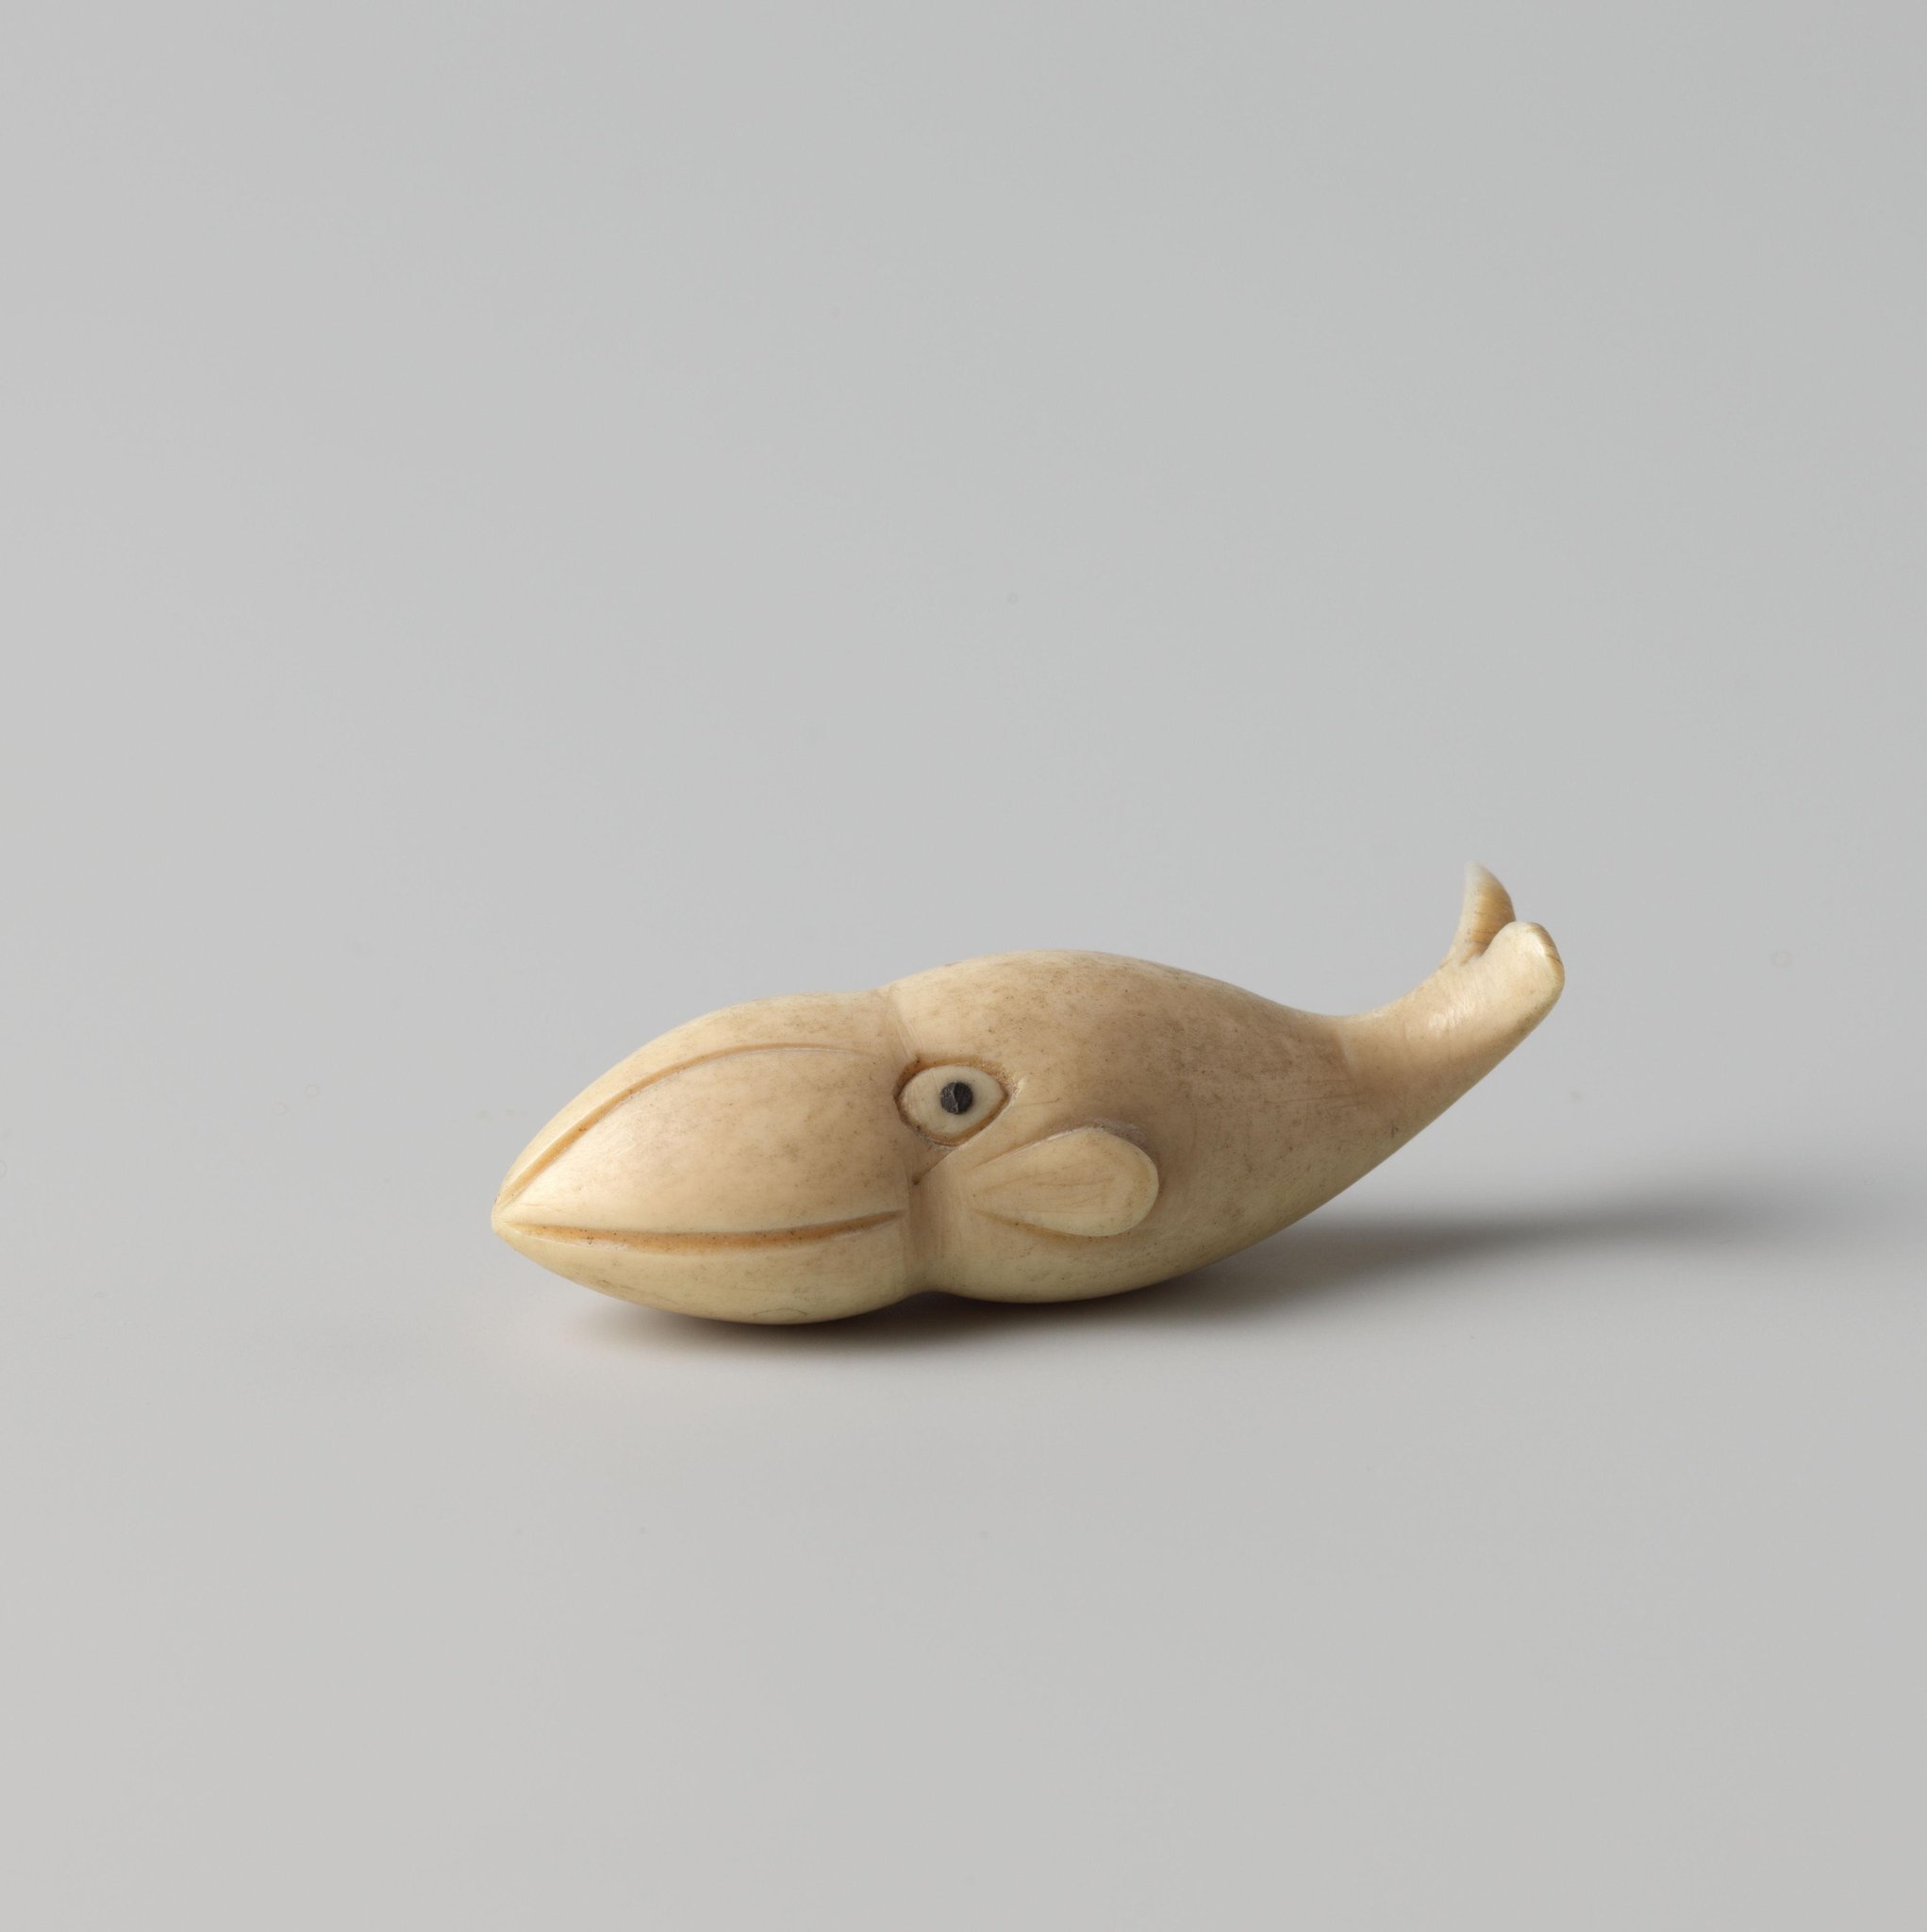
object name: figure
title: Figuur in de vorm van een walvis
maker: Anonymous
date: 1700-1900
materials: ivory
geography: china